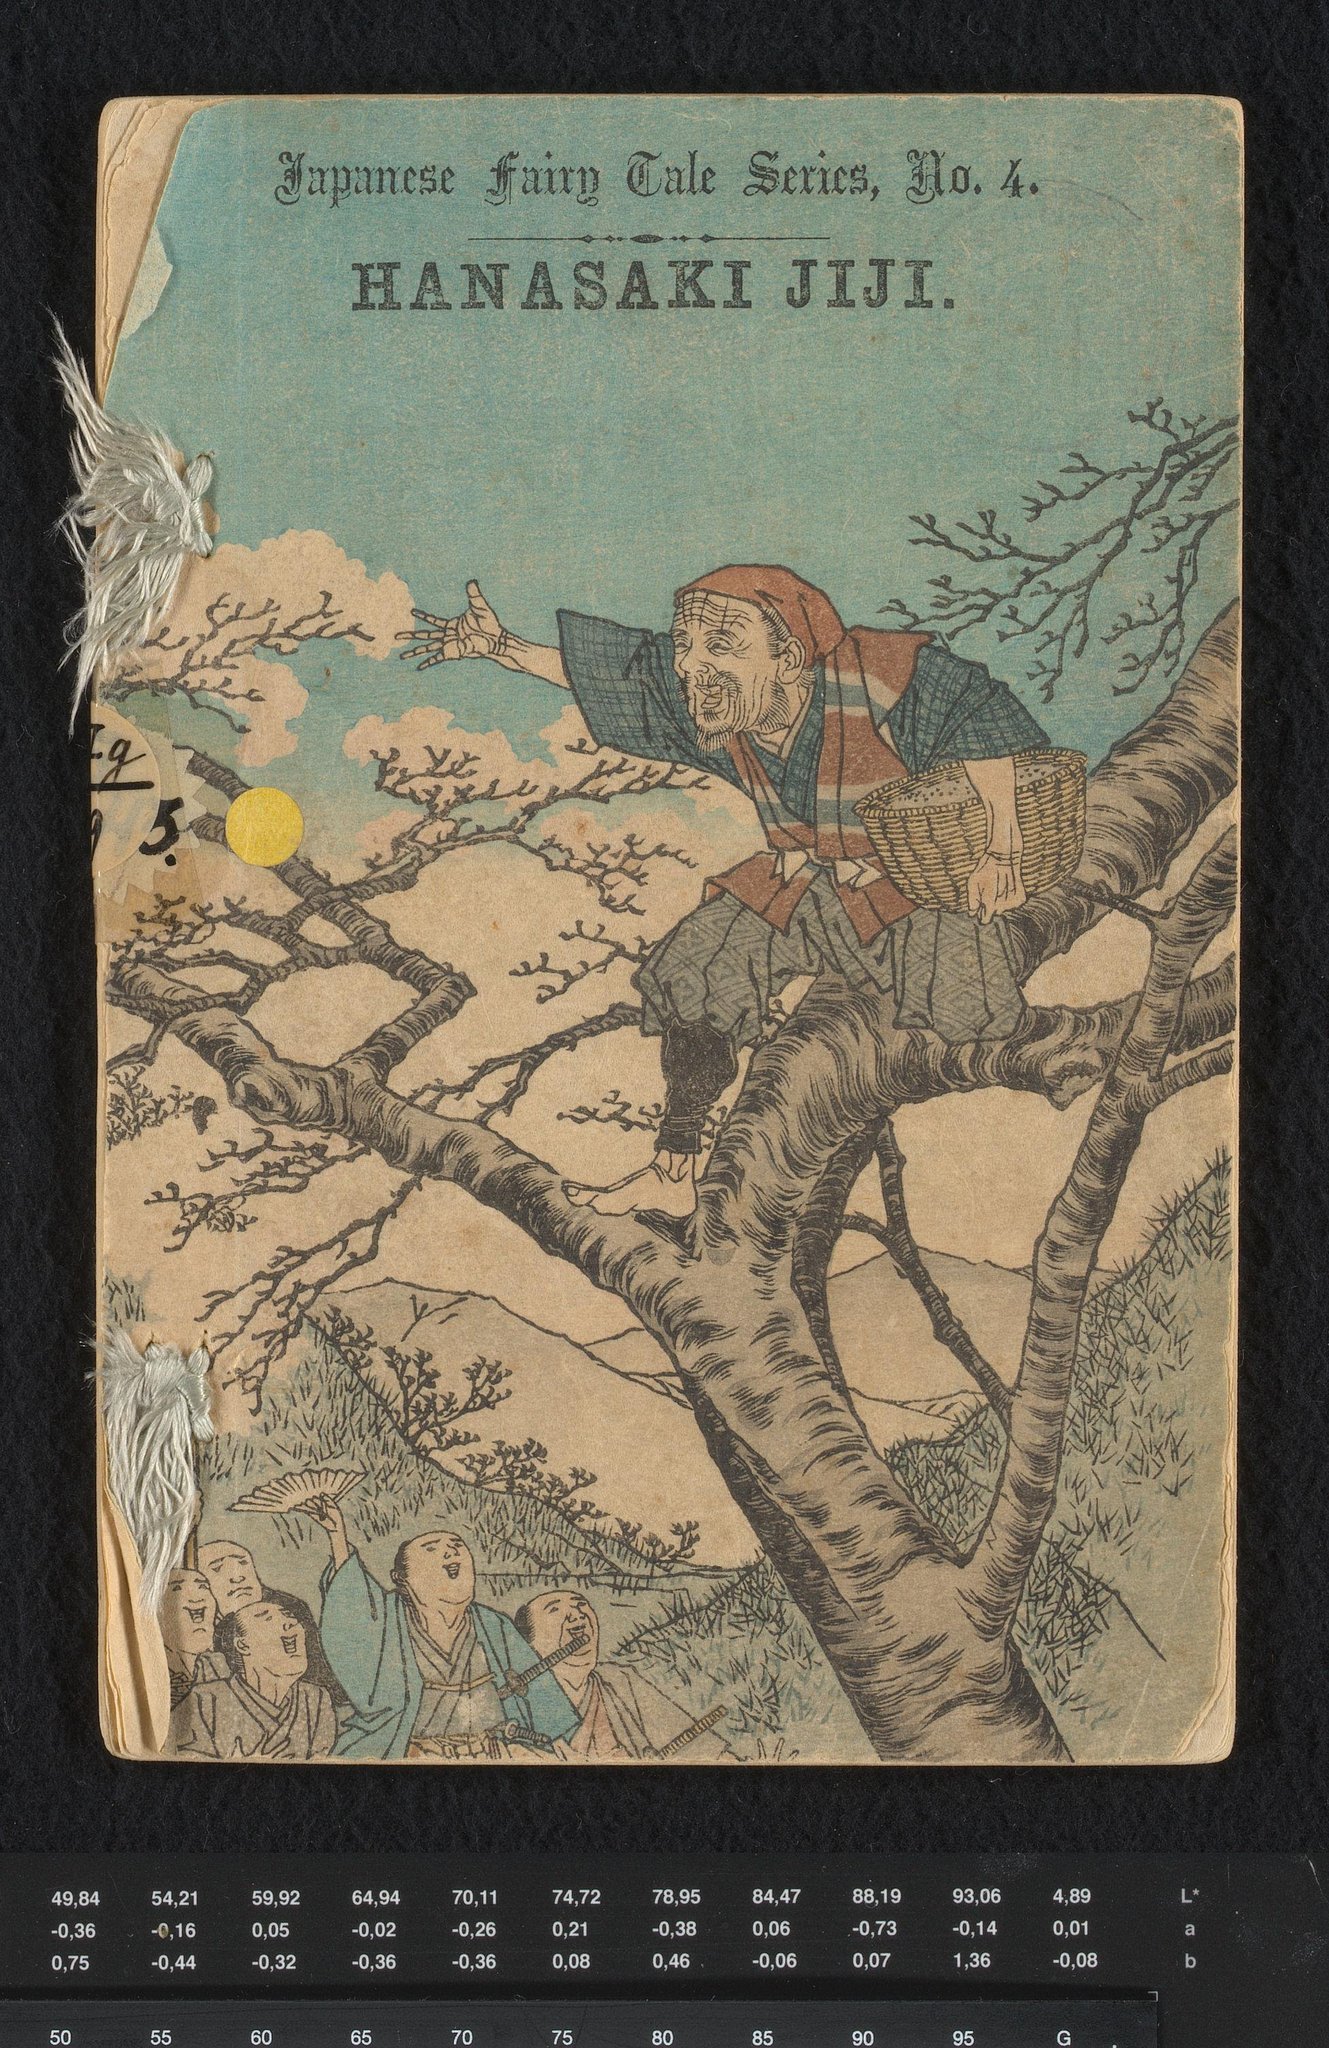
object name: book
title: Hanasaki Jiji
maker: Anonymous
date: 1880-1890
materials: paper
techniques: woodcut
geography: tokyo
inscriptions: collector's mark: Lugt 2228